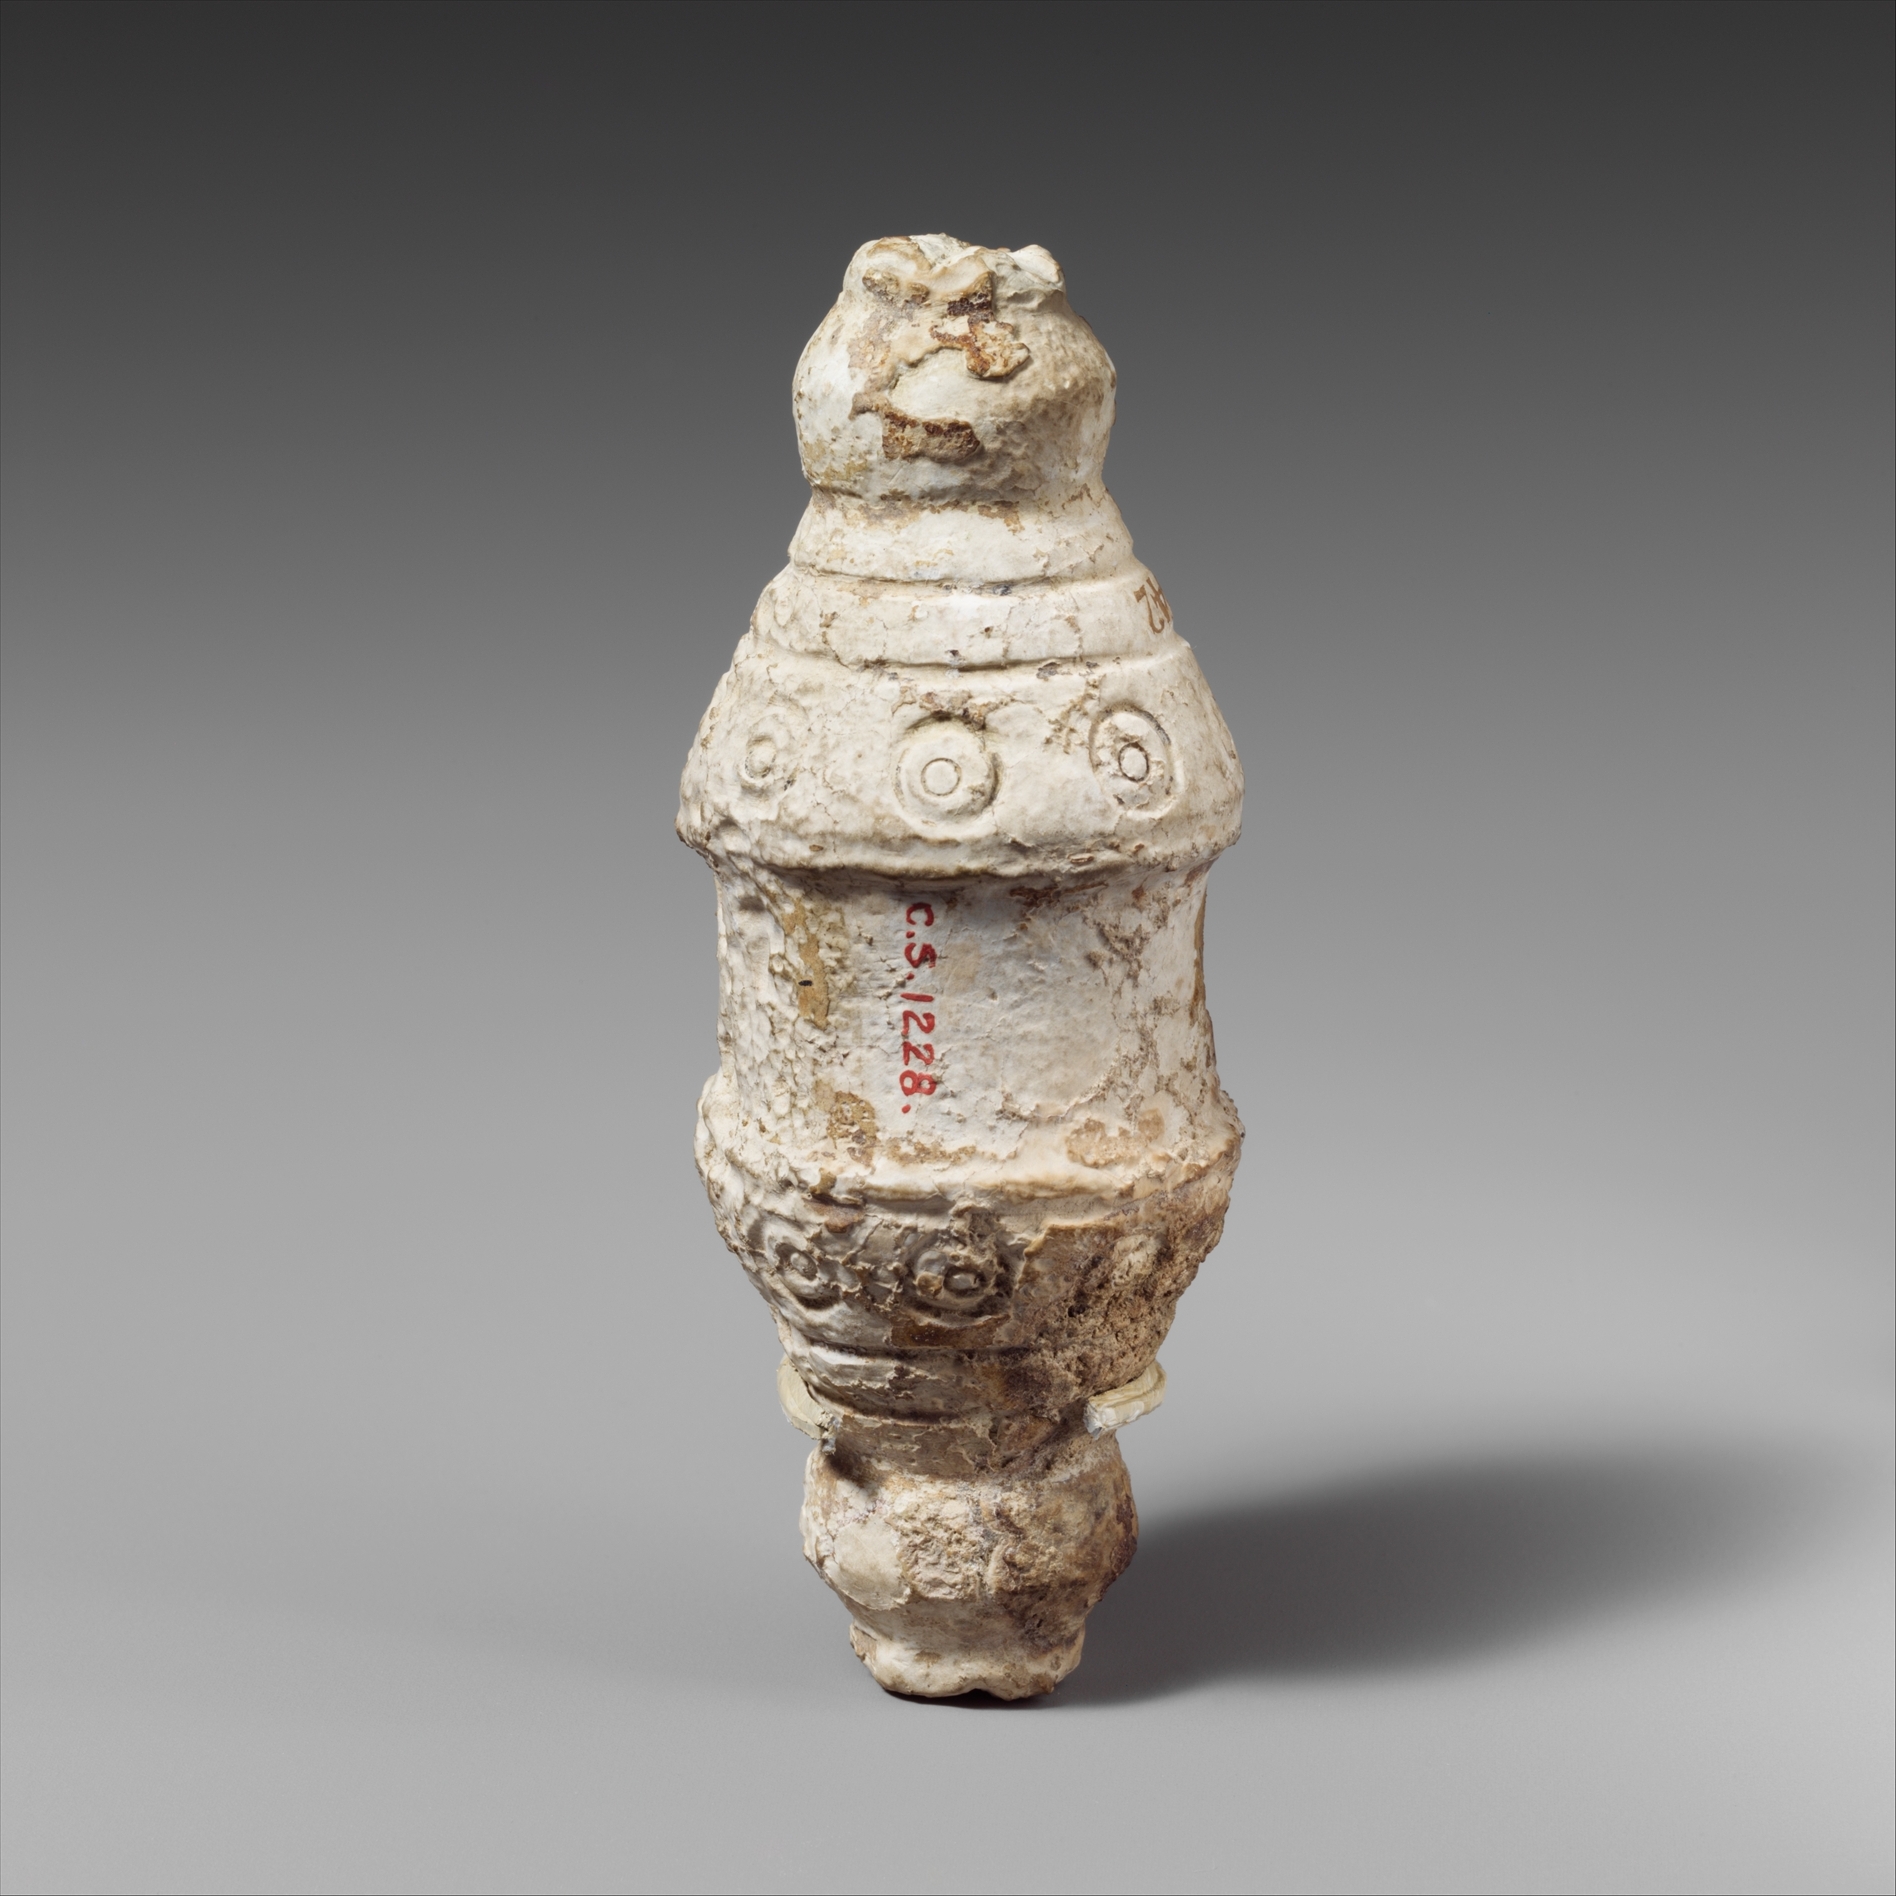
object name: spindle whorl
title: Magnesite bobbin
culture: cypriot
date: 3900 BCE-100 CE